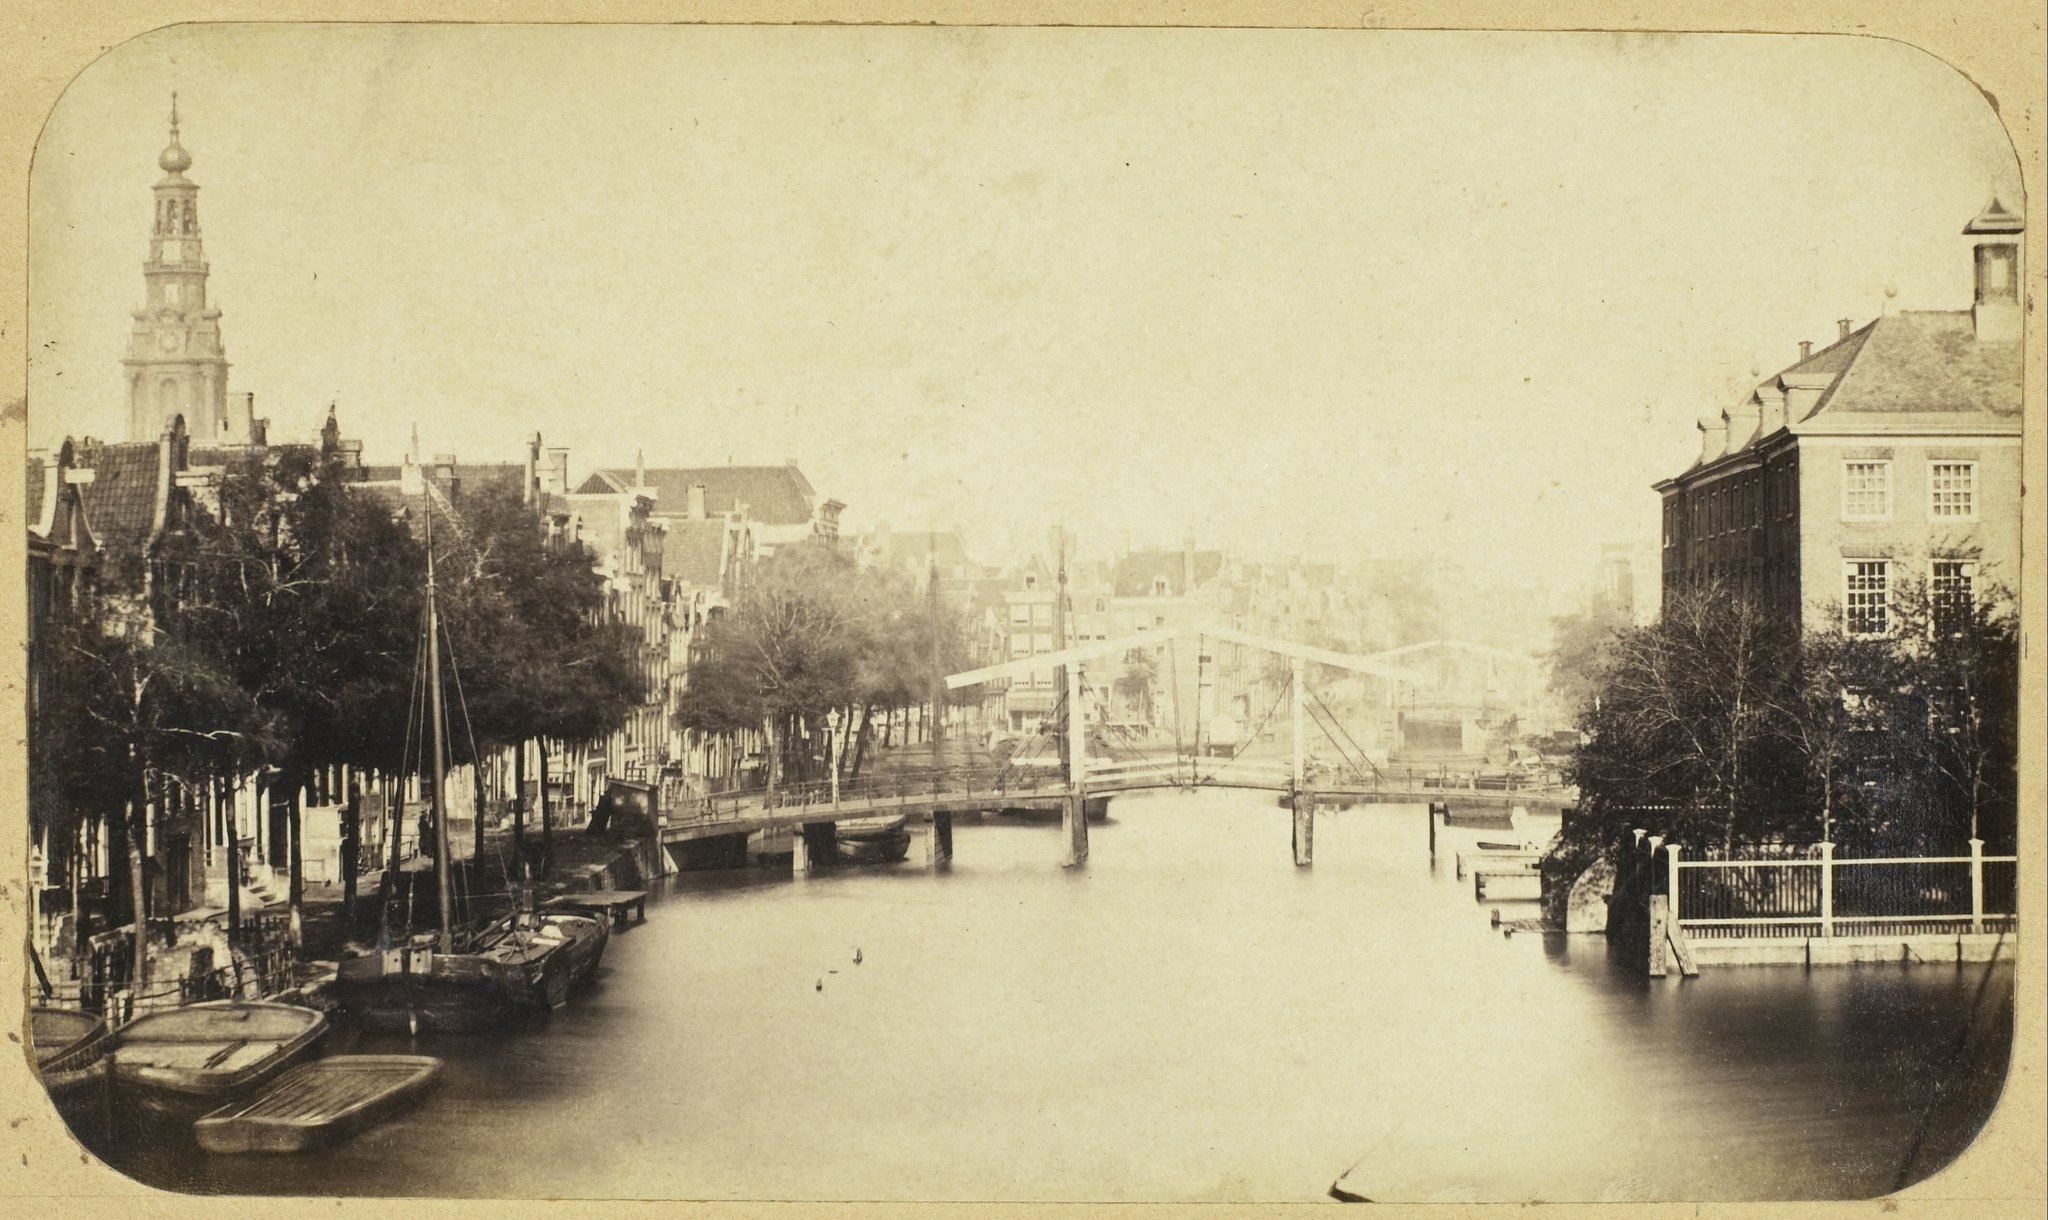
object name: photograph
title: Gezicht op de Zwanenburgwal in Amsterdam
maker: eduard isaac asser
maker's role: amateurfotograaf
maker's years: 1809-1894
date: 1853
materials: cardboard, paper, photographic support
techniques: salted paper print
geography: amsterdam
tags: zuiderkerk, zwanenburgwal, diaconieweeshuis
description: Uitzicht vanuit het huis Amstel 126 op de Zwanenburgwal met rechts het Diaconieweeshuis, Amstel 1, en geheel links op de achtergrond de toren van de Zuiderkerk. De foto is genomen vanuit de woning van de kunstschilder Johann Georg Schwartze, die op dit adres gevestigd was tot mei 1856.